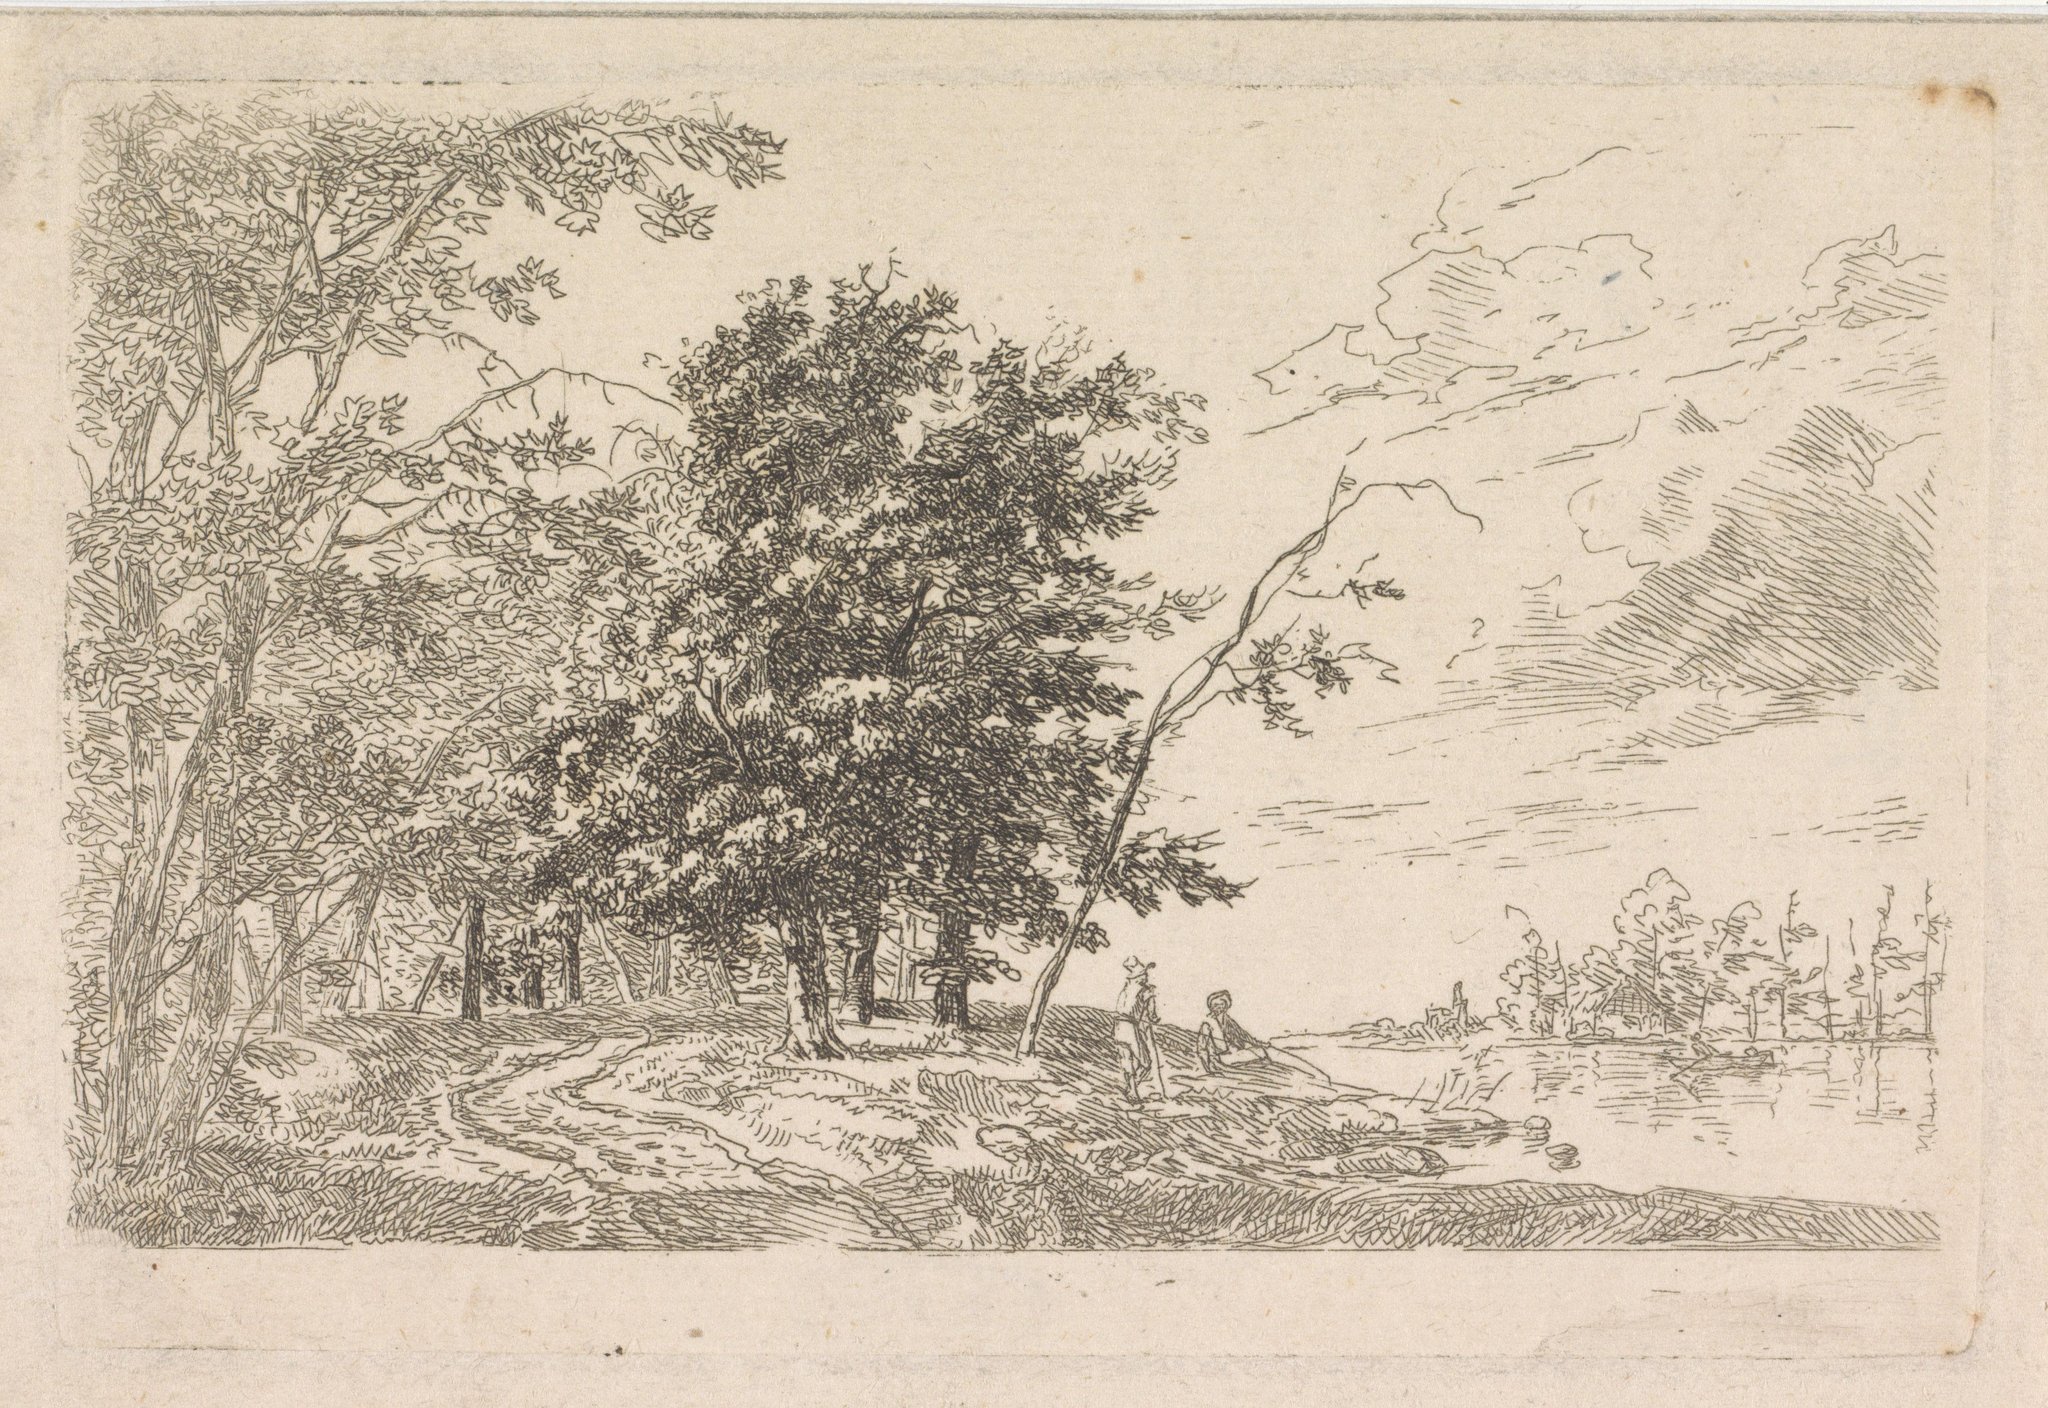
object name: print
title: Landschap met bos en rivier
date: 1800-1882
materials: paper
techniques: etching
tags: river, forest, wood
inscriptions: collector's mark: Lugt 2228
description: Landschap met links een weg en een bos. Rechts een rivier met aan de waterkant een hengelaar en een man leunend op een staf.